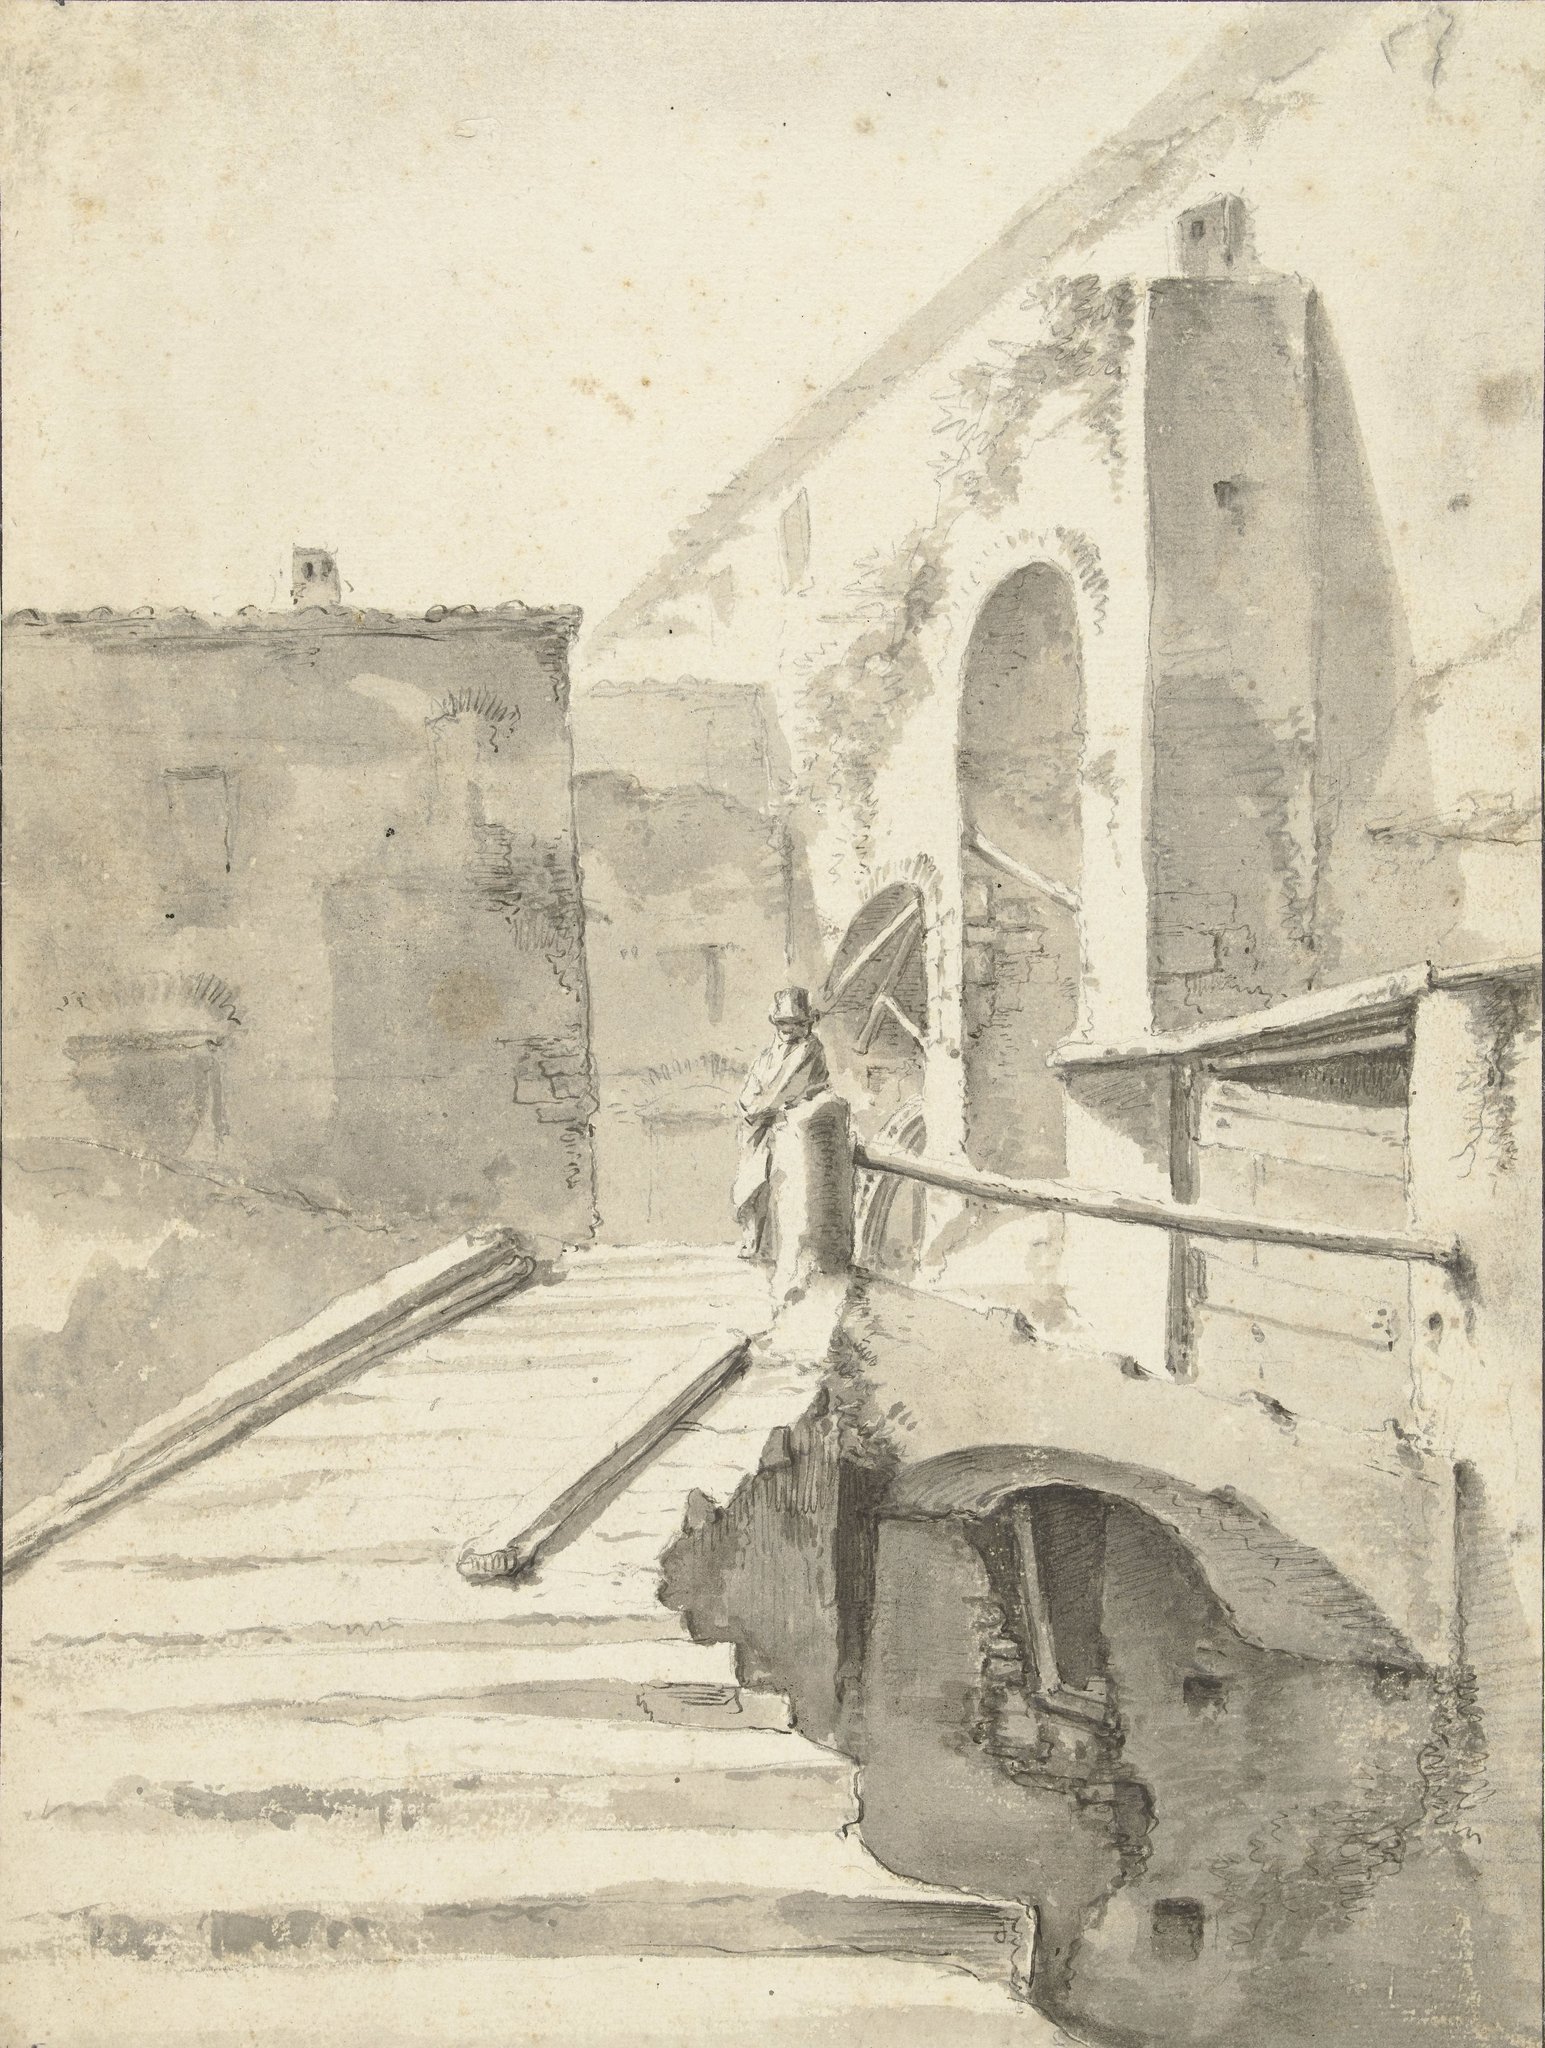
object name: drawing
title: Romeinse gebouwen en subconstructie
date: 1626-1677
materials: chalk, graphite, ink, paper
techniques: brush, pen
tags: urban housing, sloping street; street with steps or stairs, front steps, rome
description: Een man leunt tegen een zuil aan het einde van een monumentale trap.